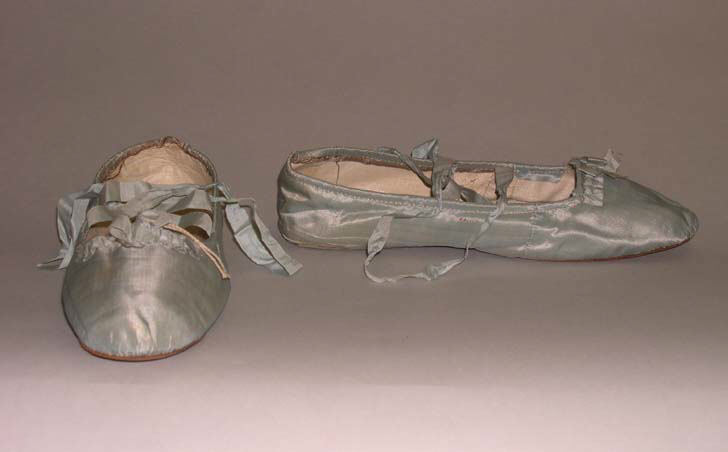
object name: slipper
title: Slippers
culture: american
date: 1801-1833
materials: silk